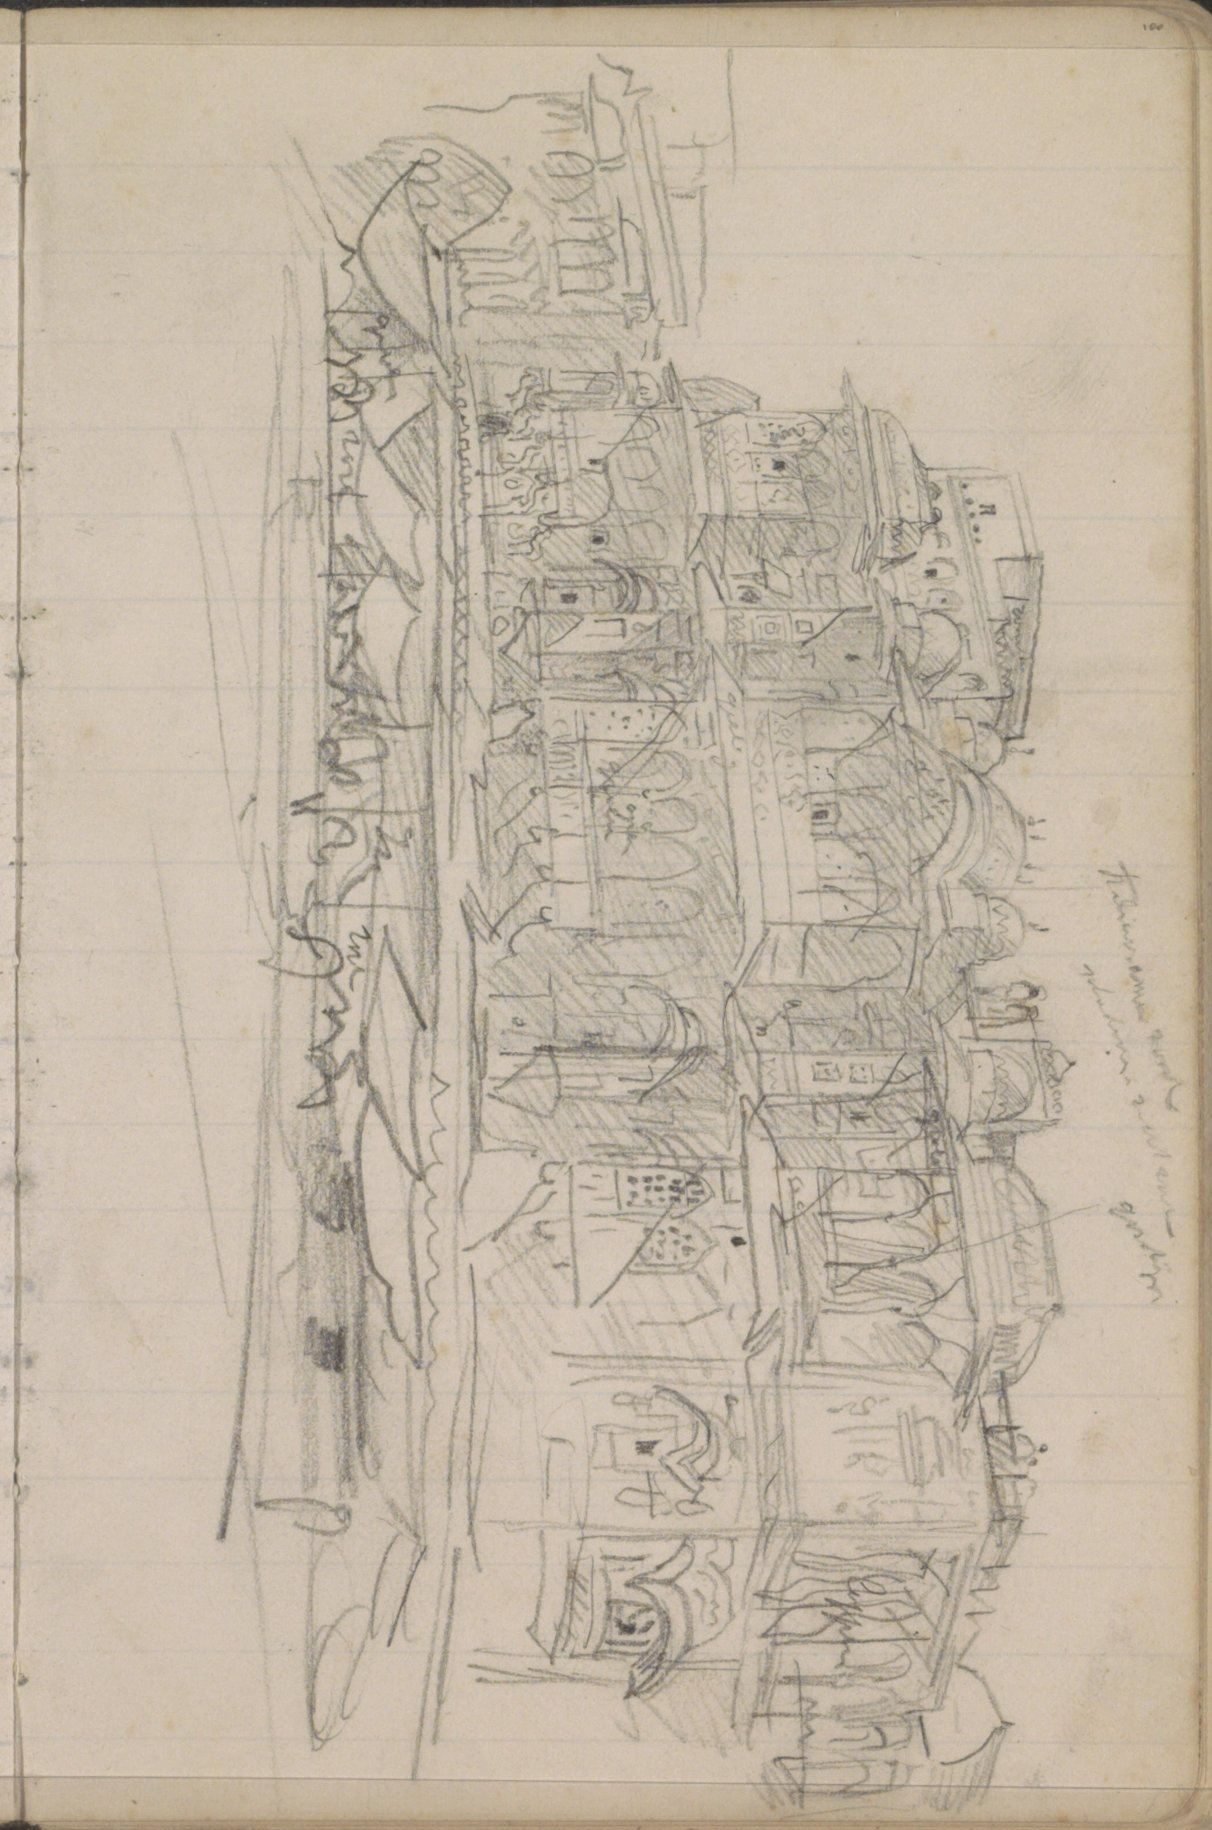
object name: sketchbook leaf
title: Rijtjeshuizen in een Indiase stad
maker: marius bauer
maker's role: draughtsman, print maker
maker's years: 1867-1932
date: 1897-1898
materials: pencil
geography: india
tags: street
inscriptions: kleurnotitie, handgeschreven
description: Pagina 101 uit een schetsboek met 84 bladen.